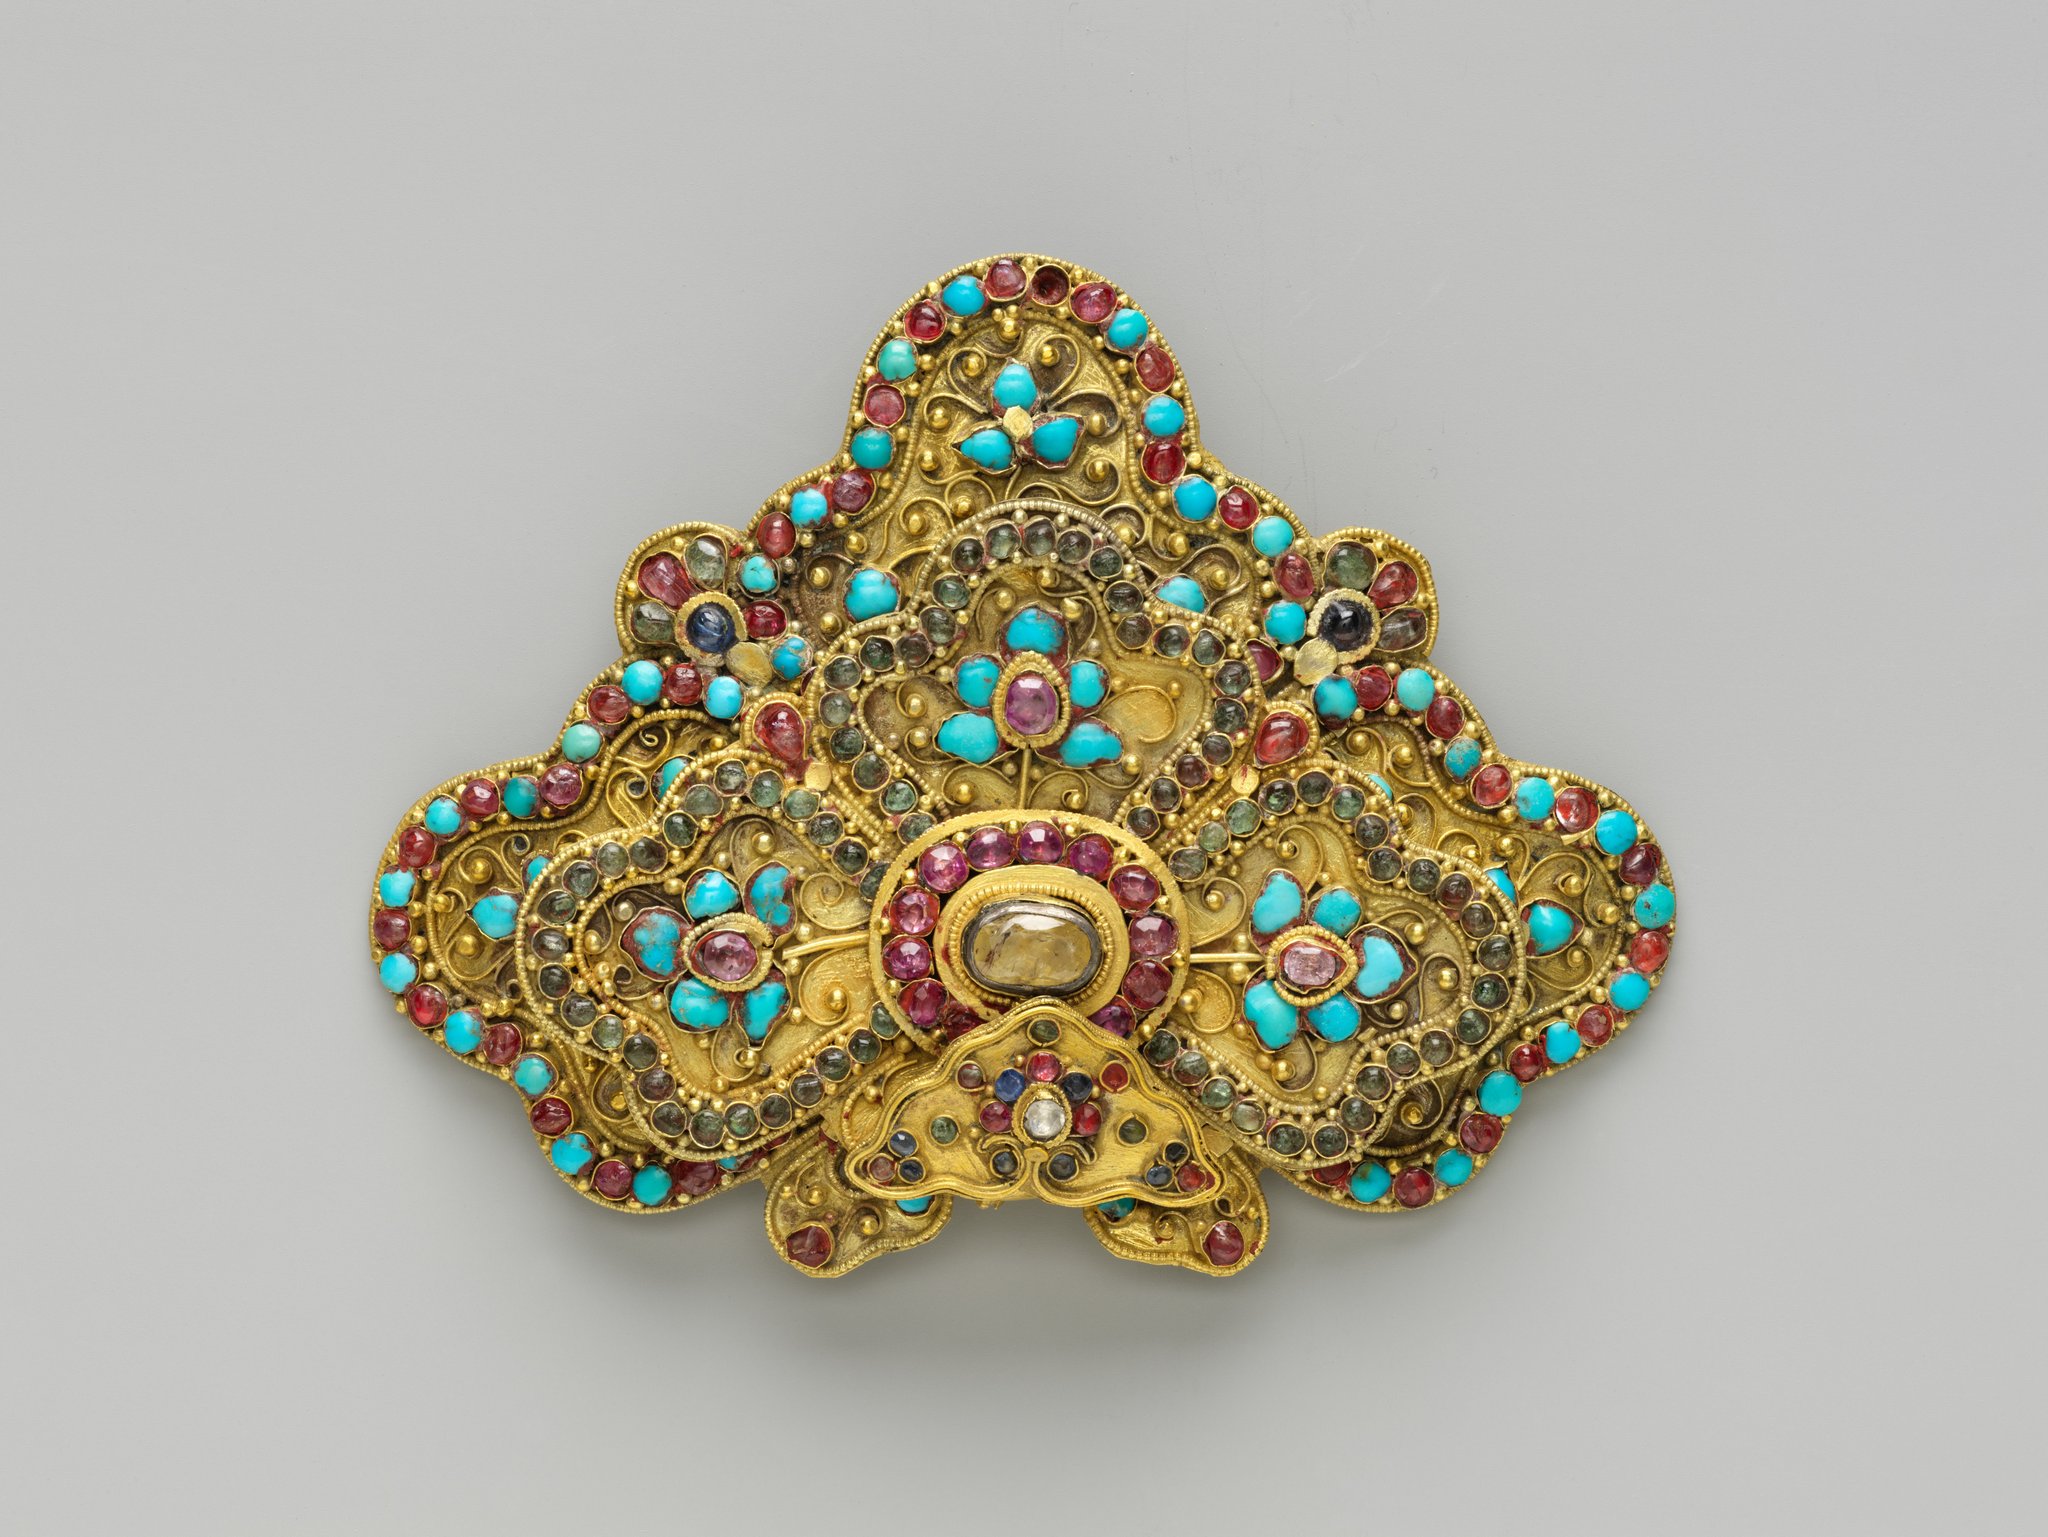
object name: plate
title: Women’s Pendant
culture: nepali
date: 1601-1900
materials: gemstone, gold